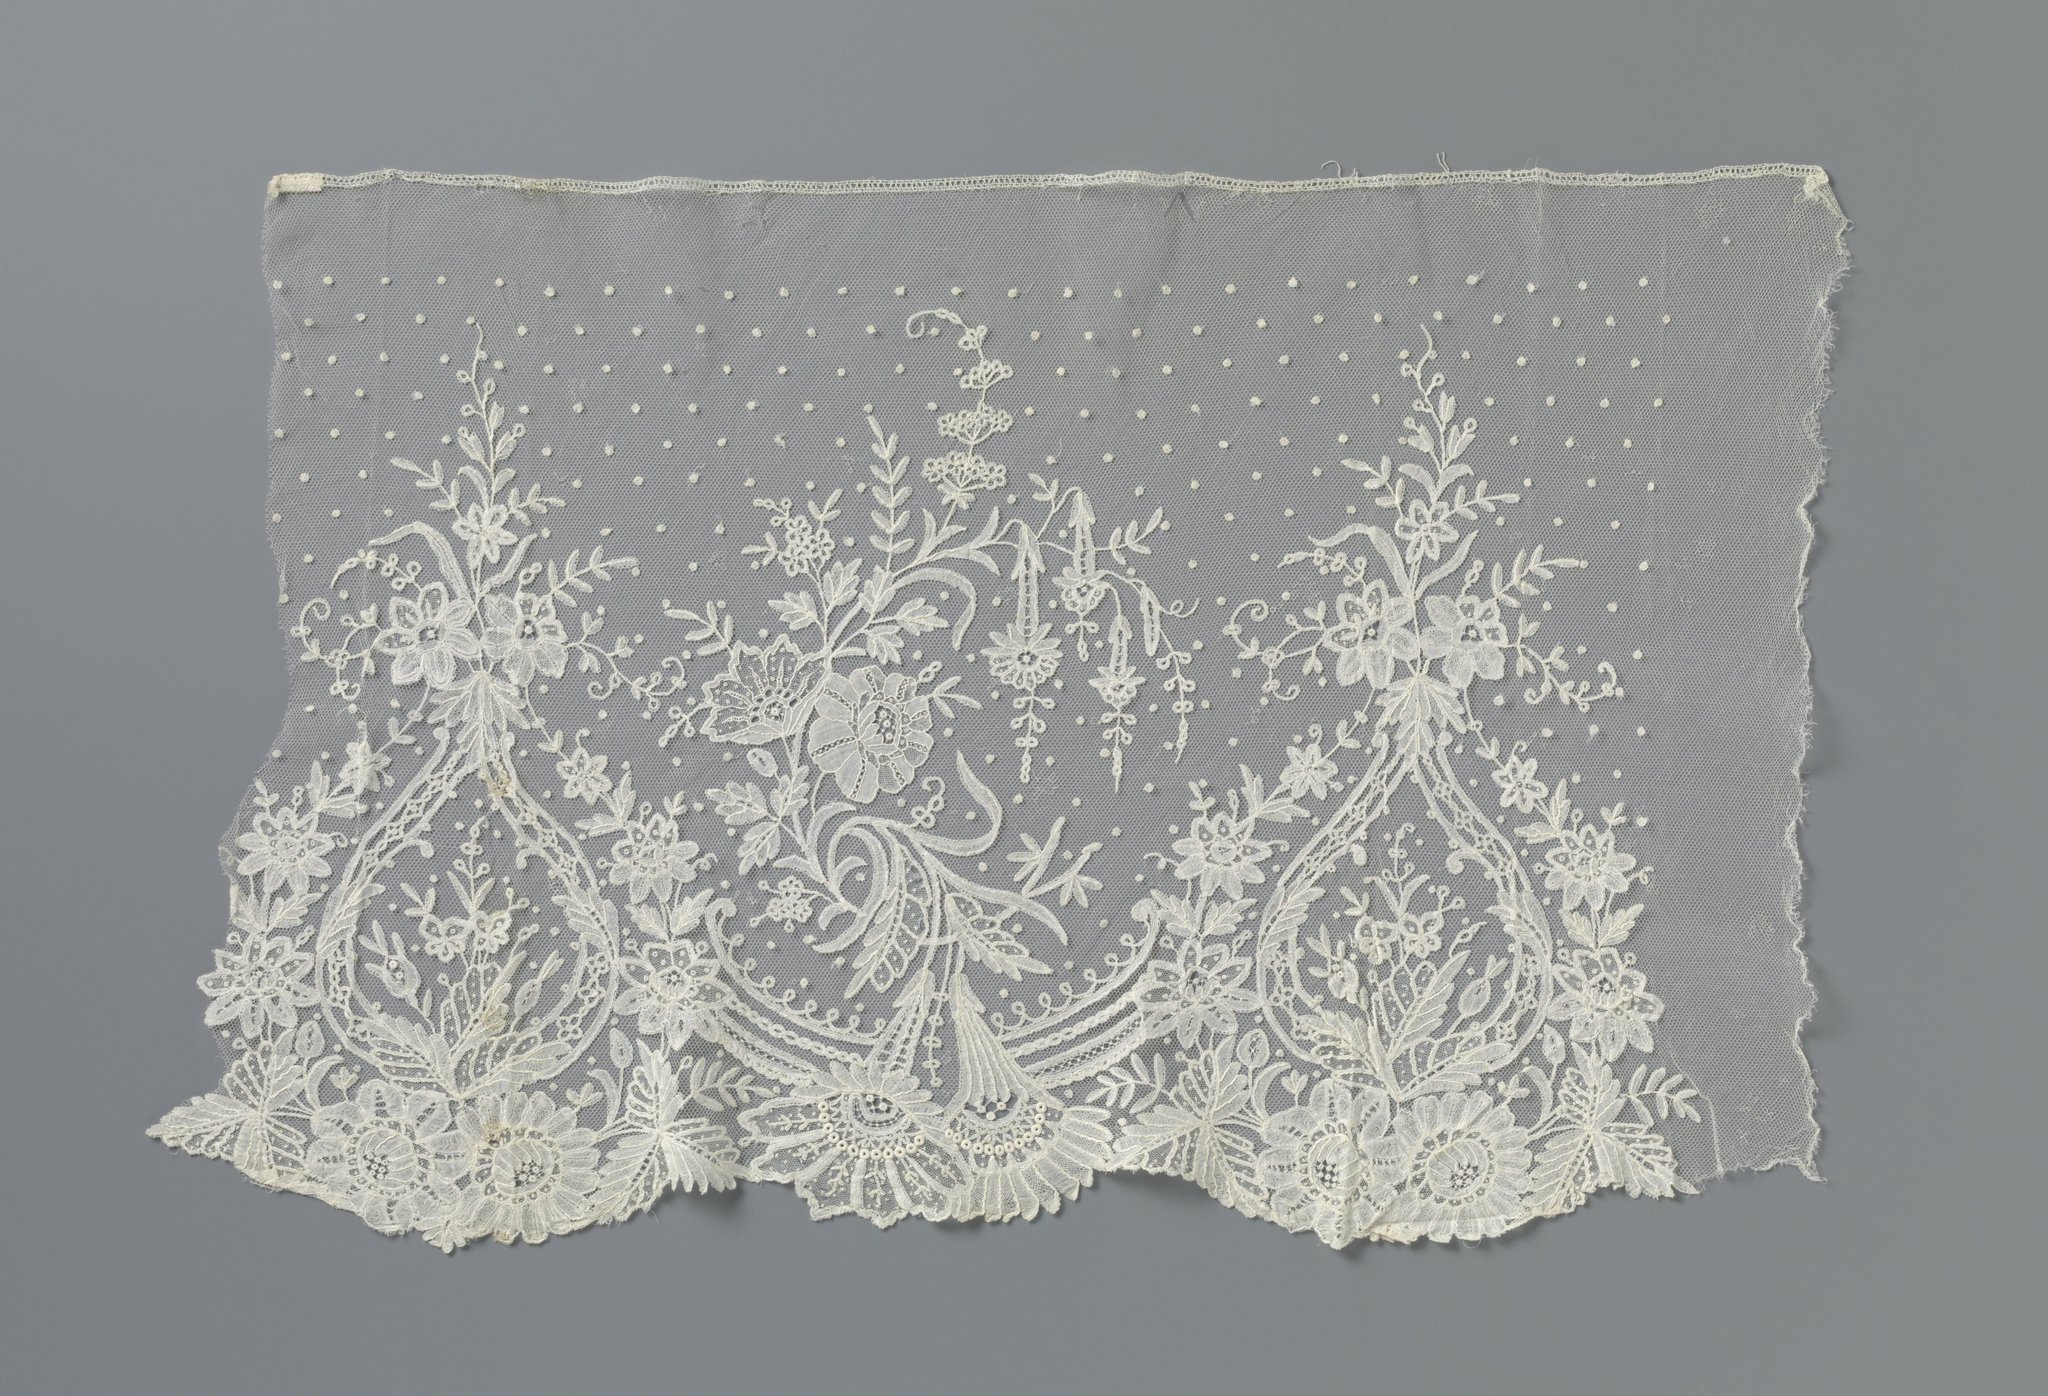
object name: sleeve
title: Mouw van applicatiekant met de peervormige medaillons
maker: Anonymous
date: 1840-1849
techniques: lace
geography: brussels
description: Mouw van naturelkleurige applicatiekant, kloskant en naaldkant geappliceerd op machinale tule. Tegen een achtergrond, die wijd bezaaid is met moesjes, zijn gesloten gewerkte schulpen beurtelings gevuld met een peervormig medaillon met viooltjes en een cirkelboog met een bloemtak. De peervorm is omgeven door een bloemkrans met een bloemtakje in de top. De tak boven de cirkelboog is c-vormig gezwenkt en vertoont twee grote afhangende kelkbloemen, een duinroosje en een anemoon (beide van naaldkant) en hangende klokjes.